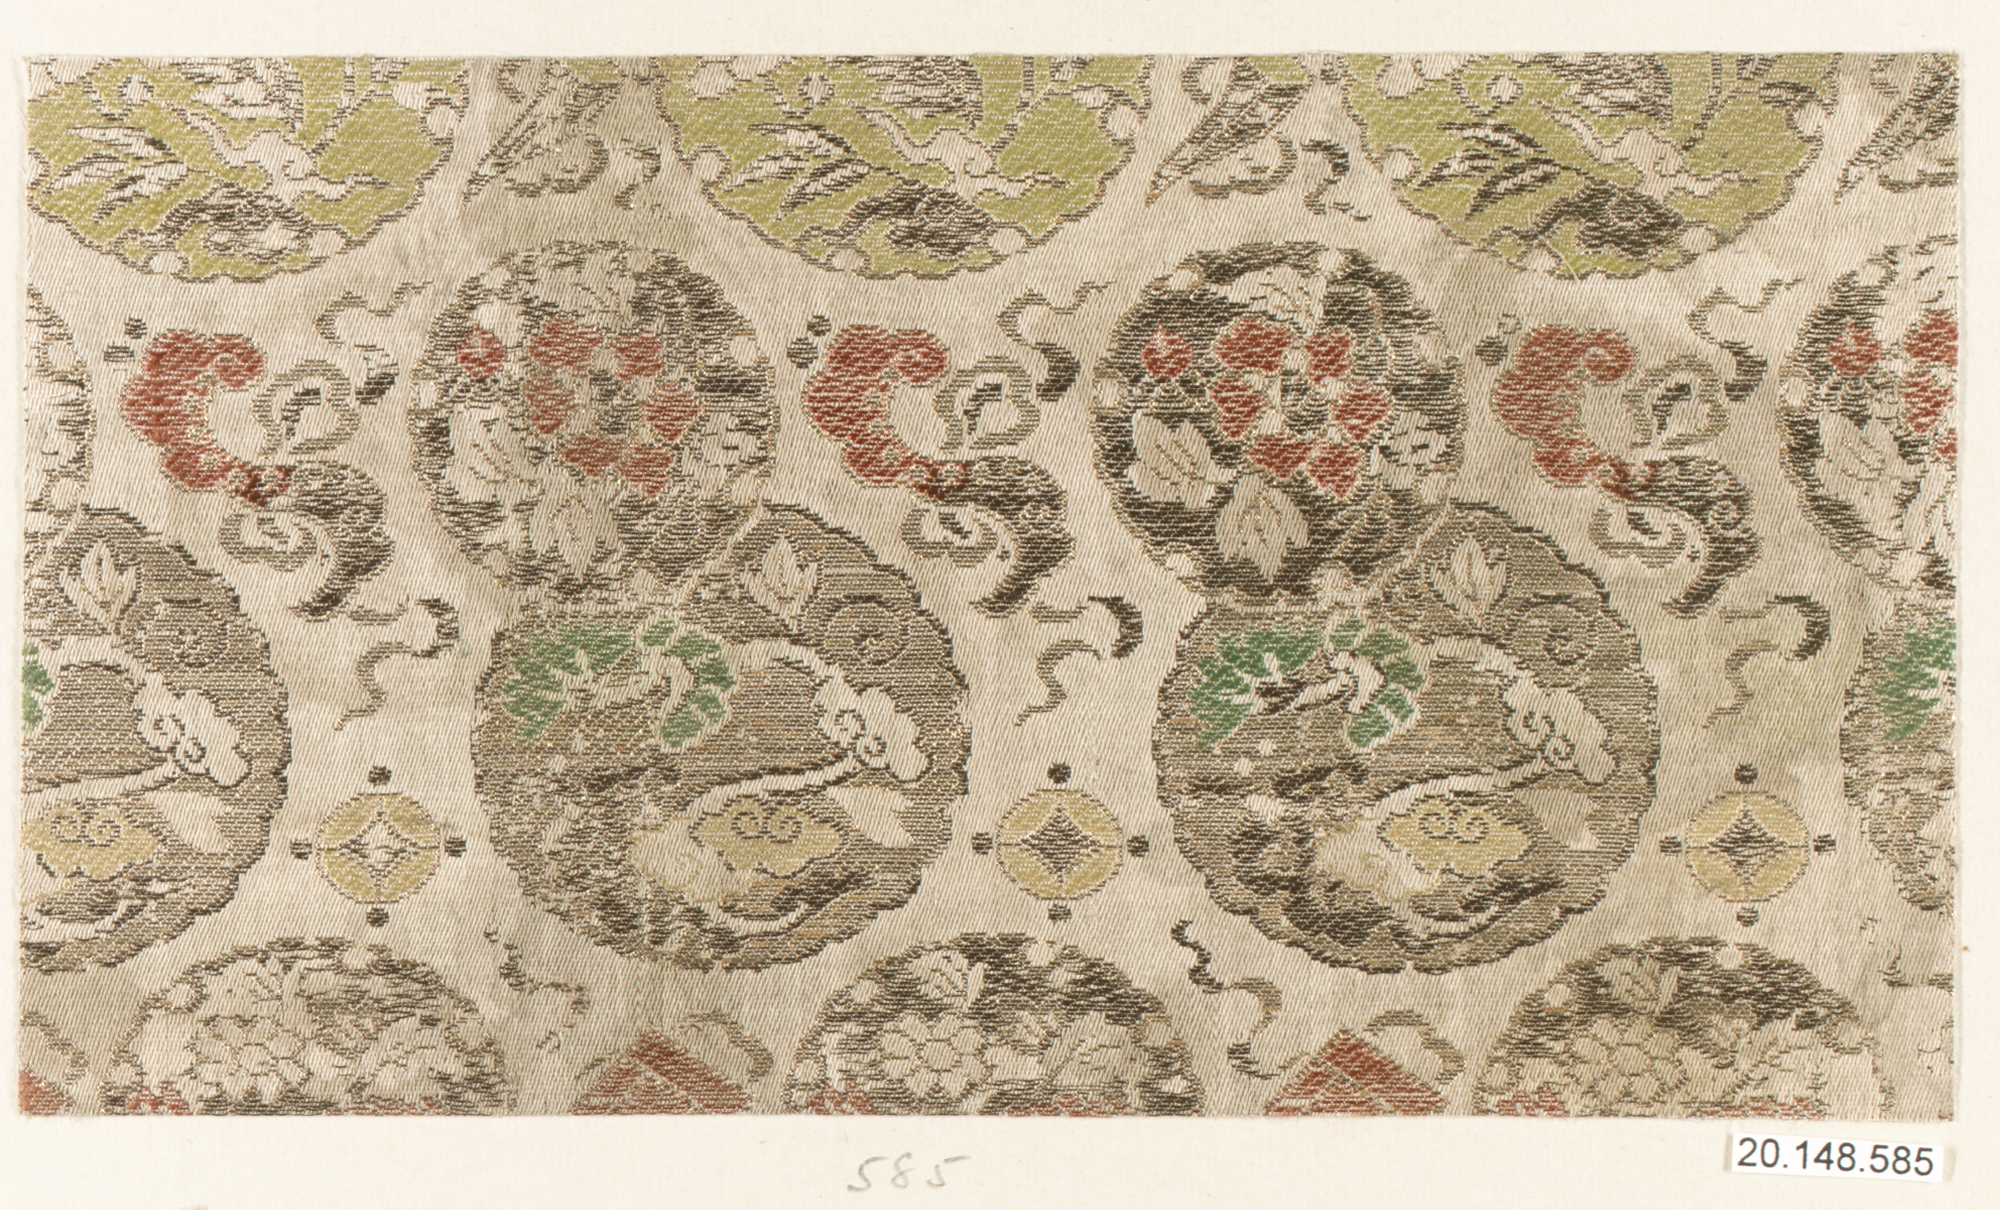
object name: piece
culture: japanese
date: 1701-1800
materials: silk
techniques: compound weave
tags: flowers